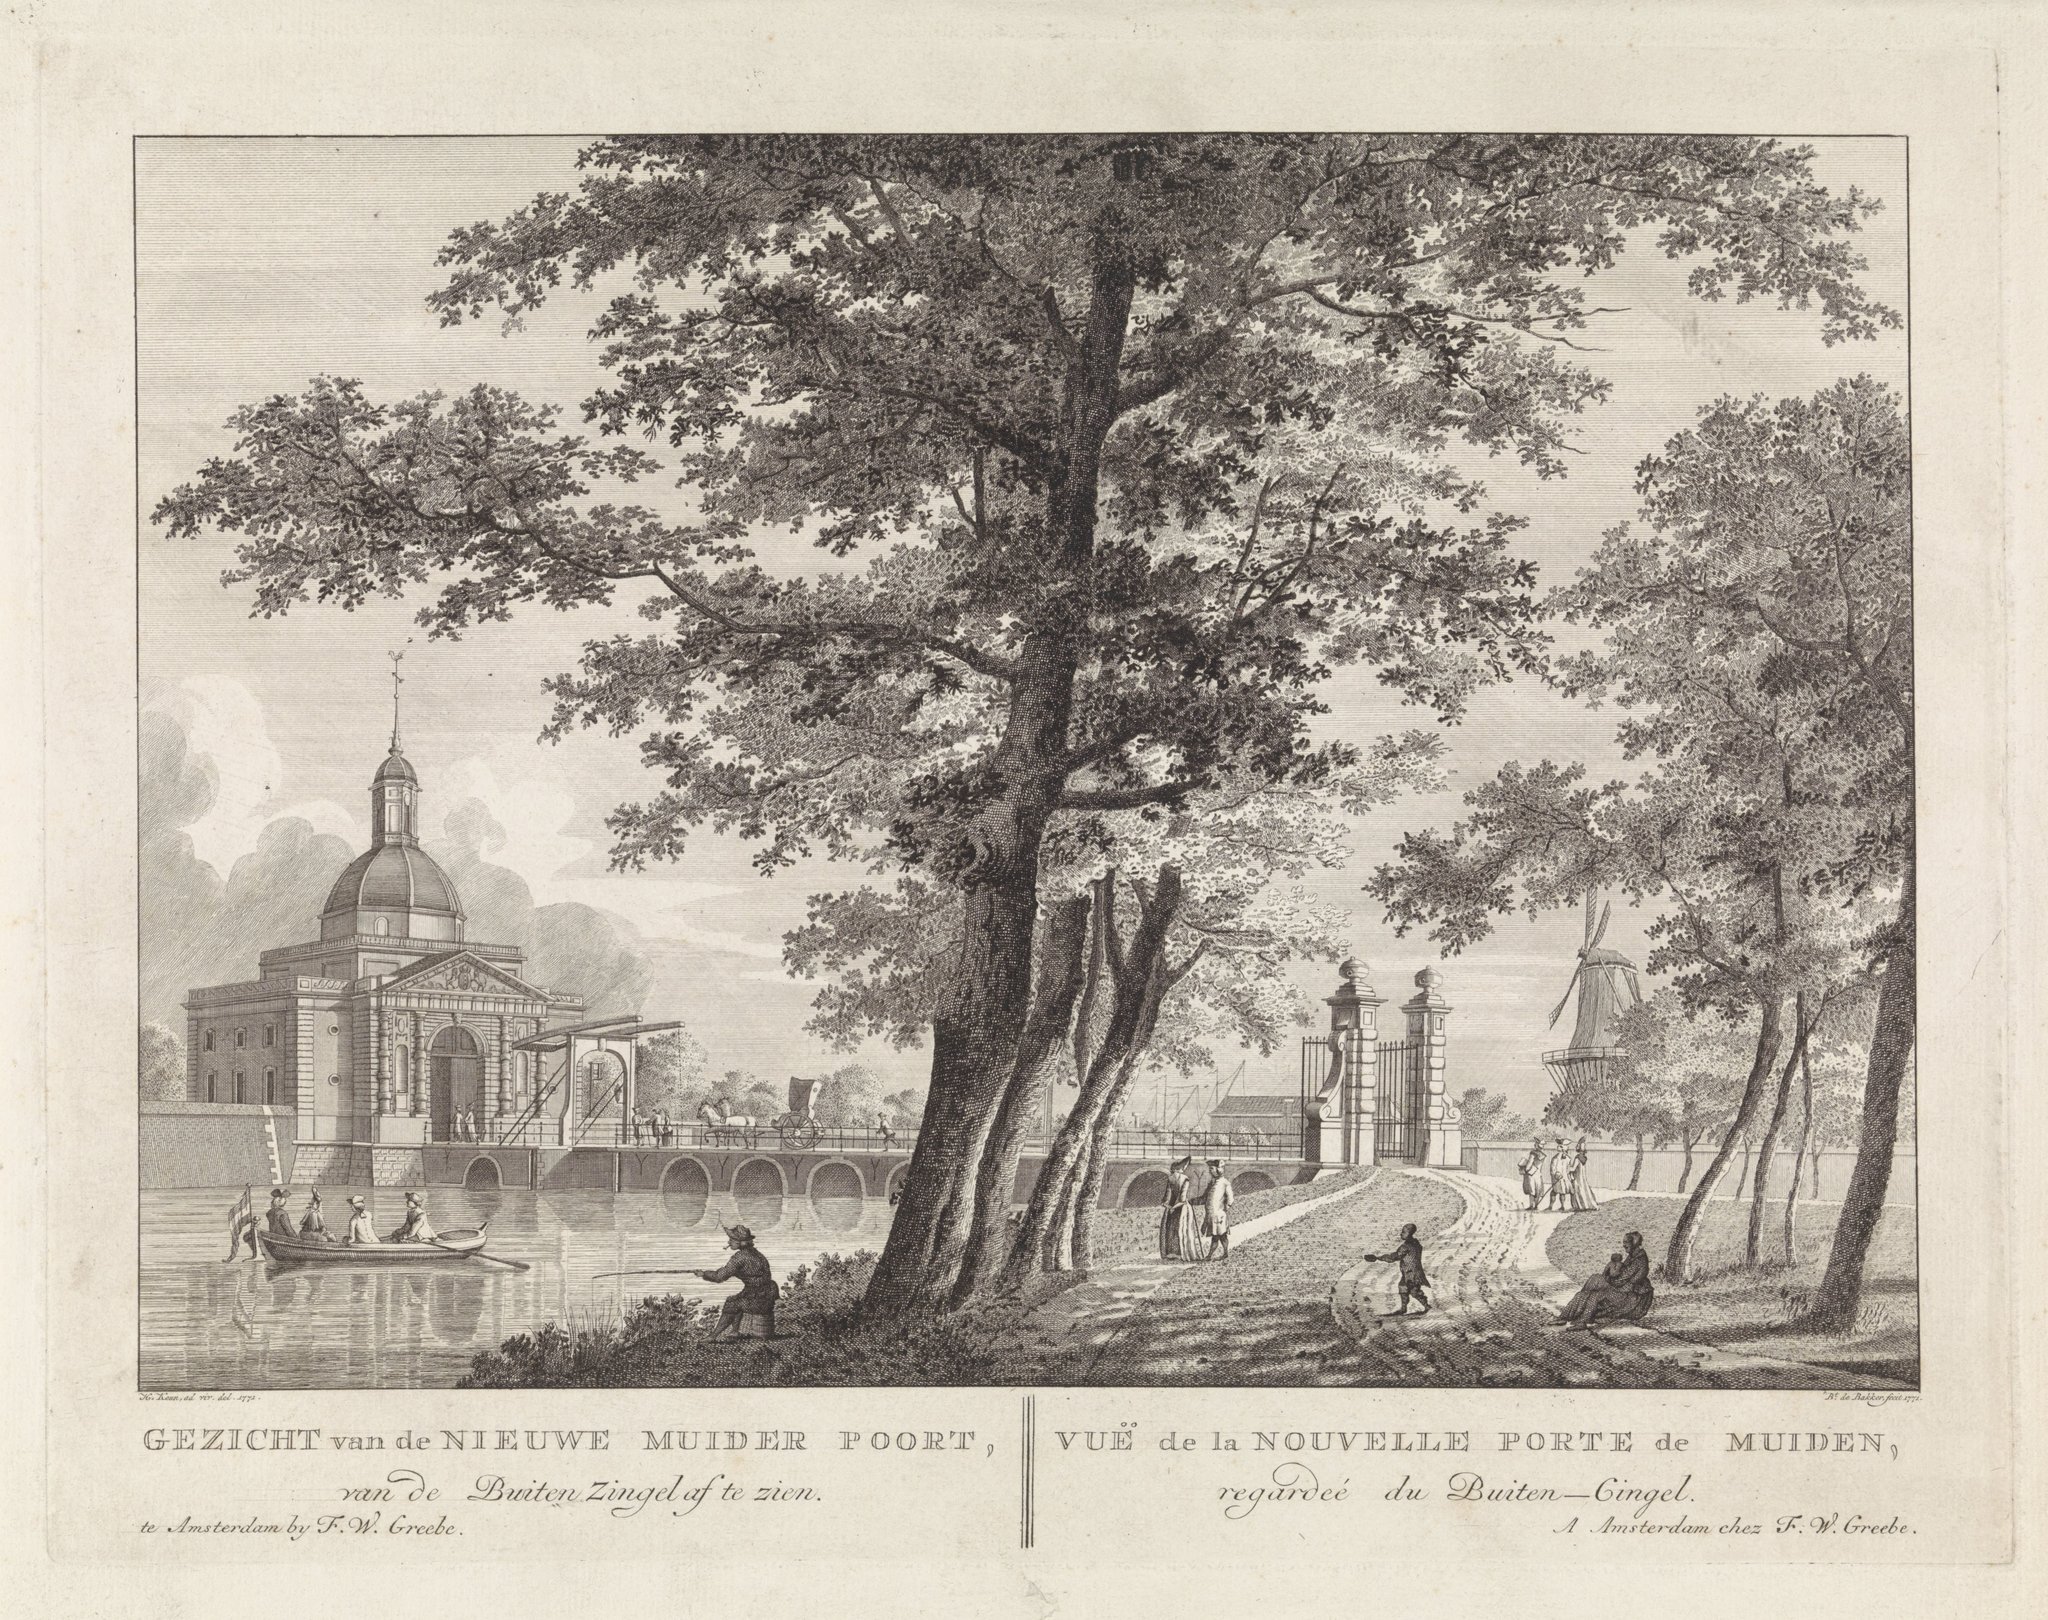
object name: print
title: Gezicht op nieuwe Muiderpoort te Amsterdam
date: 1772-1804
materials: paper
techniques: engraving, etching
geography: amsterdam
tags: city-gate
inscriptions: collector's mark: Lugt 2228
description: Prent naar tekening van Hendrik Keun (gedateerd 1772).